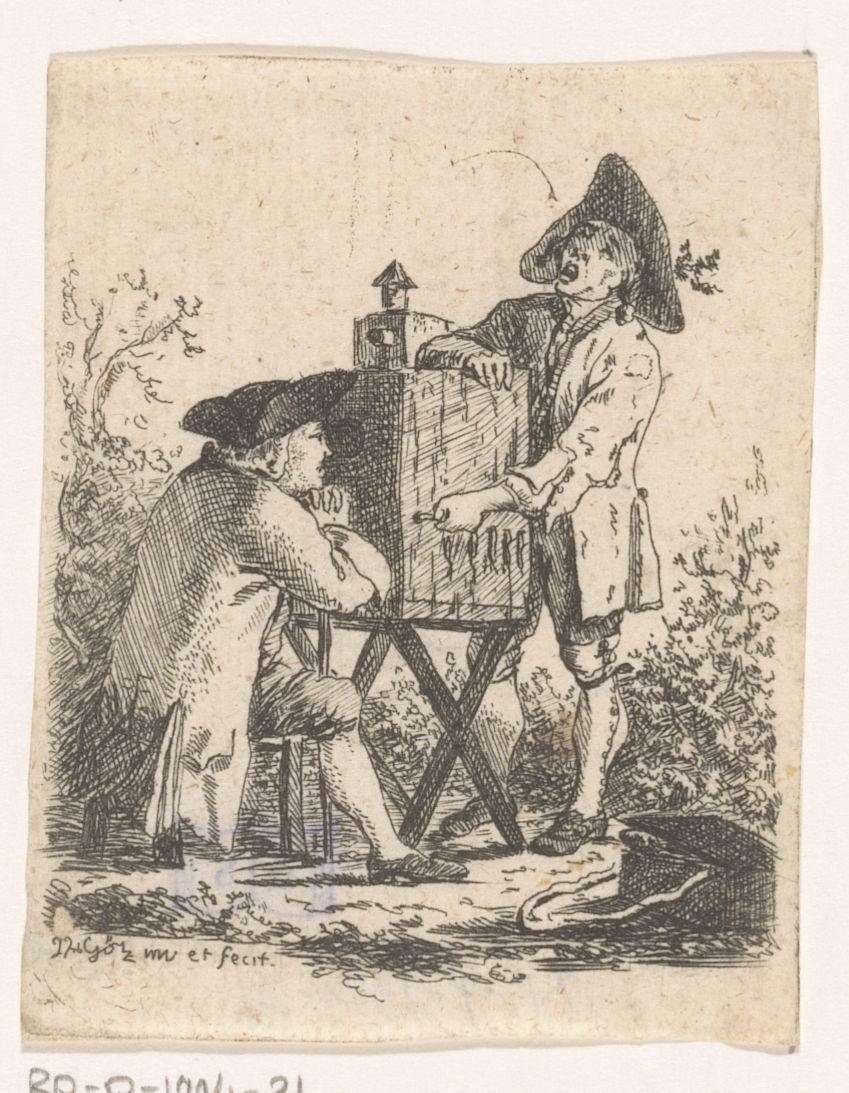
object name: print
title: Twee mannen bij een toverlantaarn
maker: joseph franz freiherr von goez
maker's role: print maker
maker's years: 1754-1815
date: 1764-1815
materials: paper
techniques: etching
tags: magic lantern, vocal music, singing, peep-show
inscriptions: collector's mark: Lugt 2228